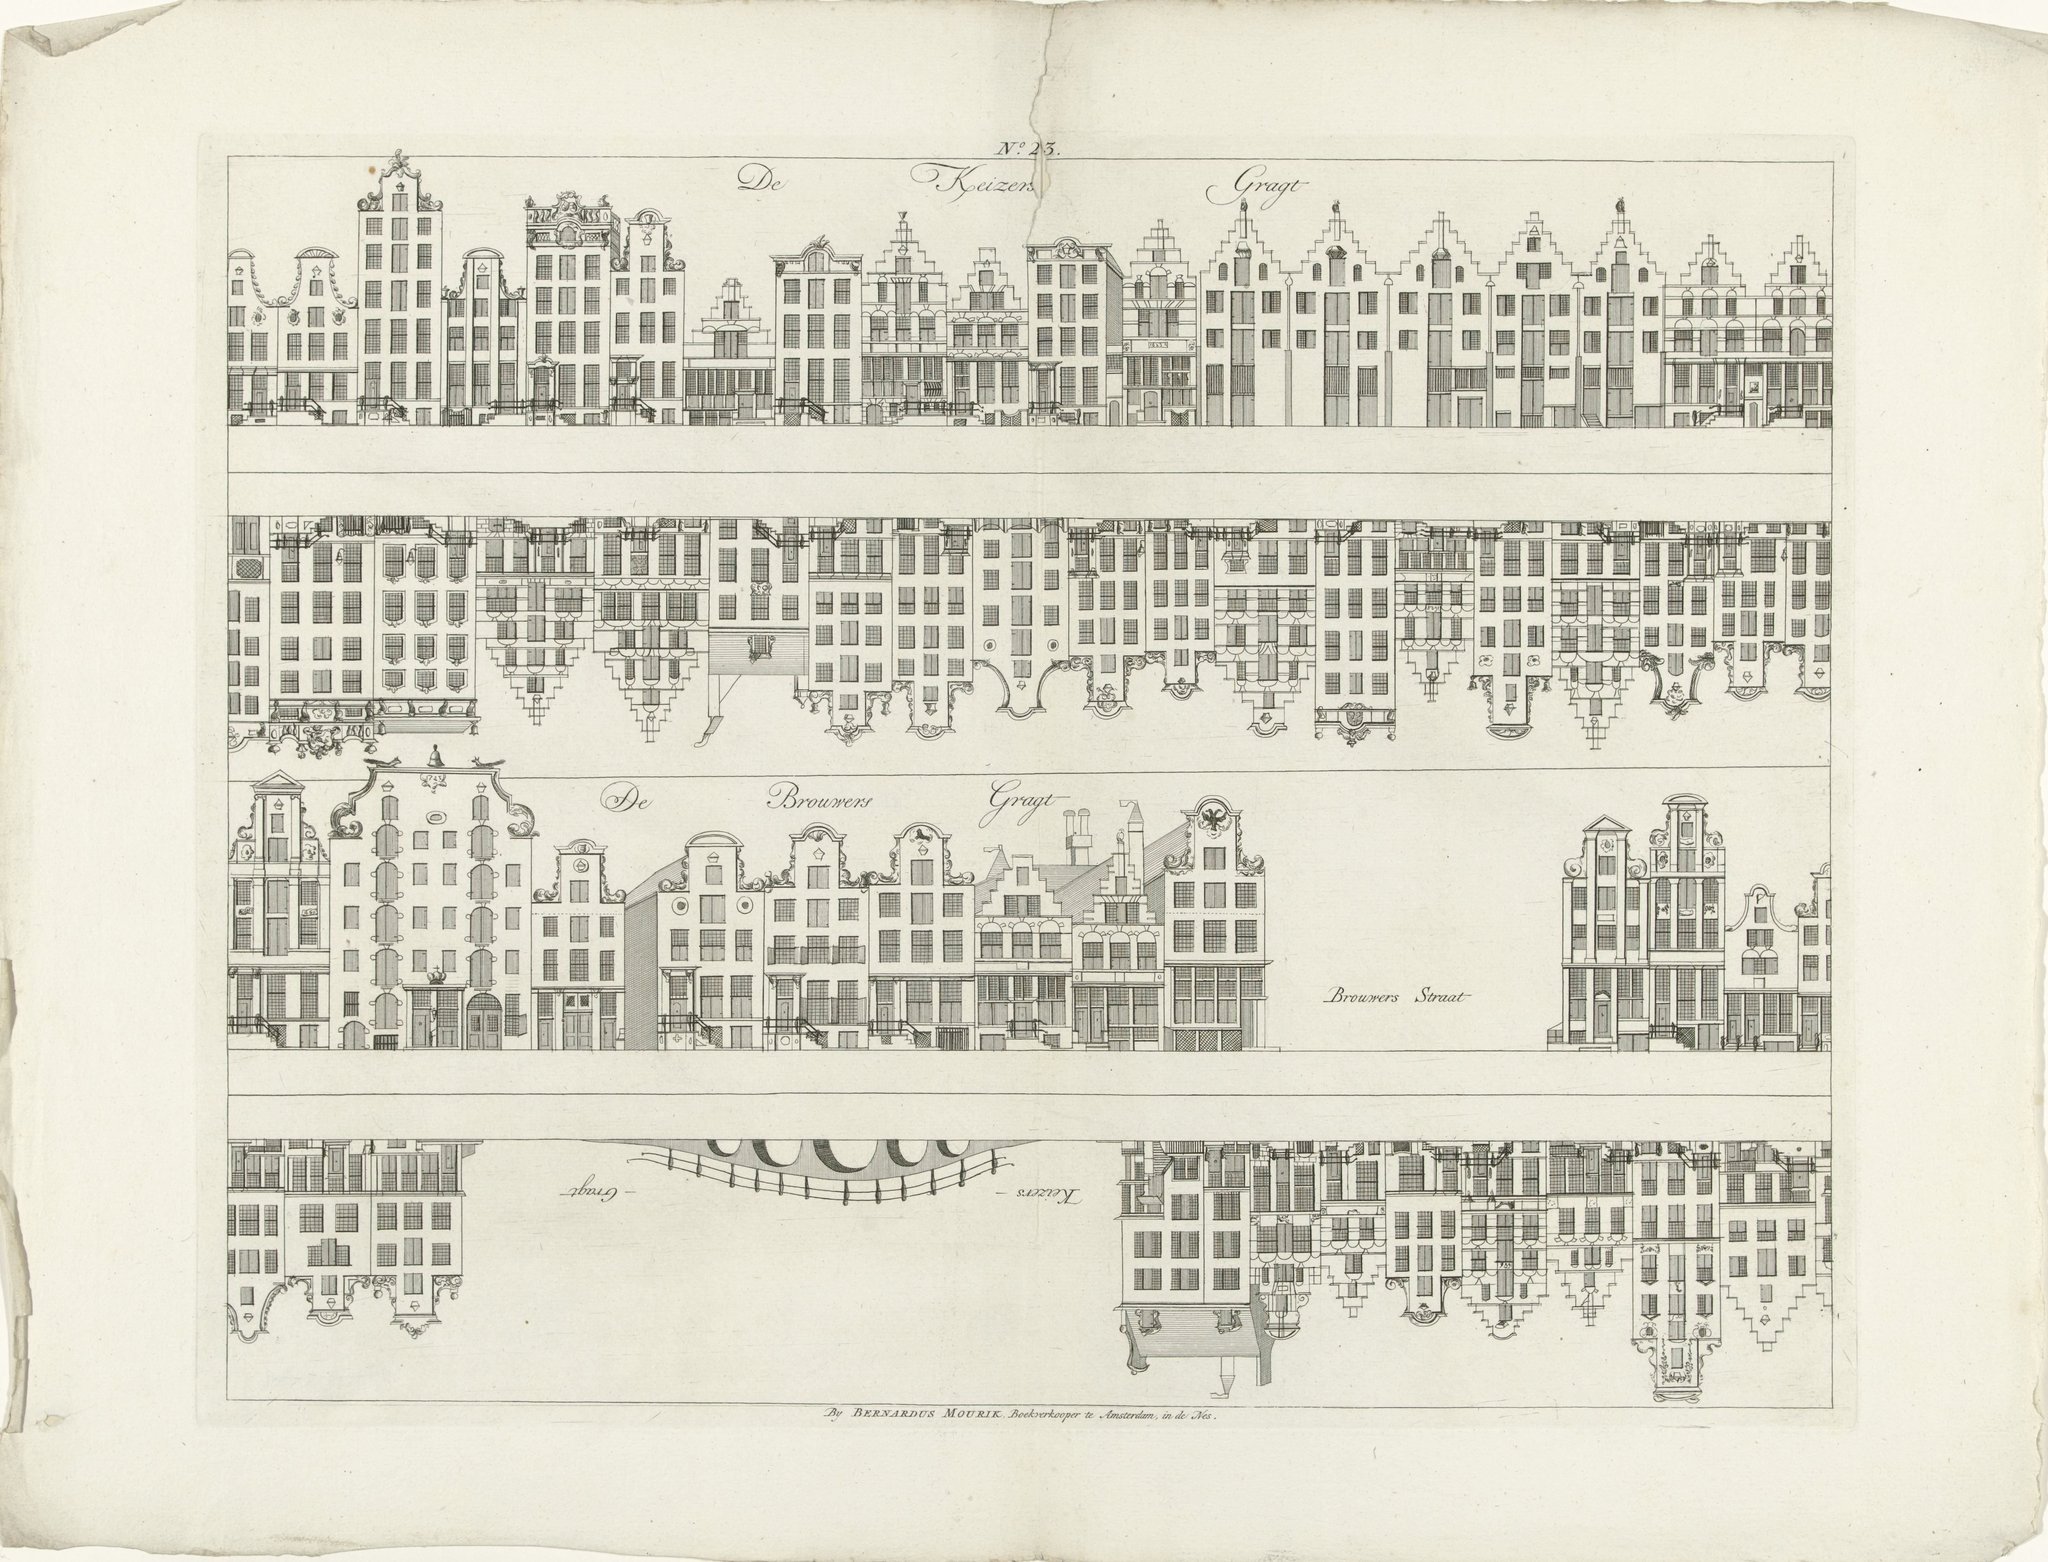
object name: print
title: Verzameling van alle De Huizen en Gebouwen langs de Keizers en Heeren-Grachten der Stad Amsterdam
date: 1768-1771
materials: paper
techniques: etching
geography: amsterdam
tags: front façade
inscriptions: collector's mark: Lugt 2233, collector's mark: Lugt 2228